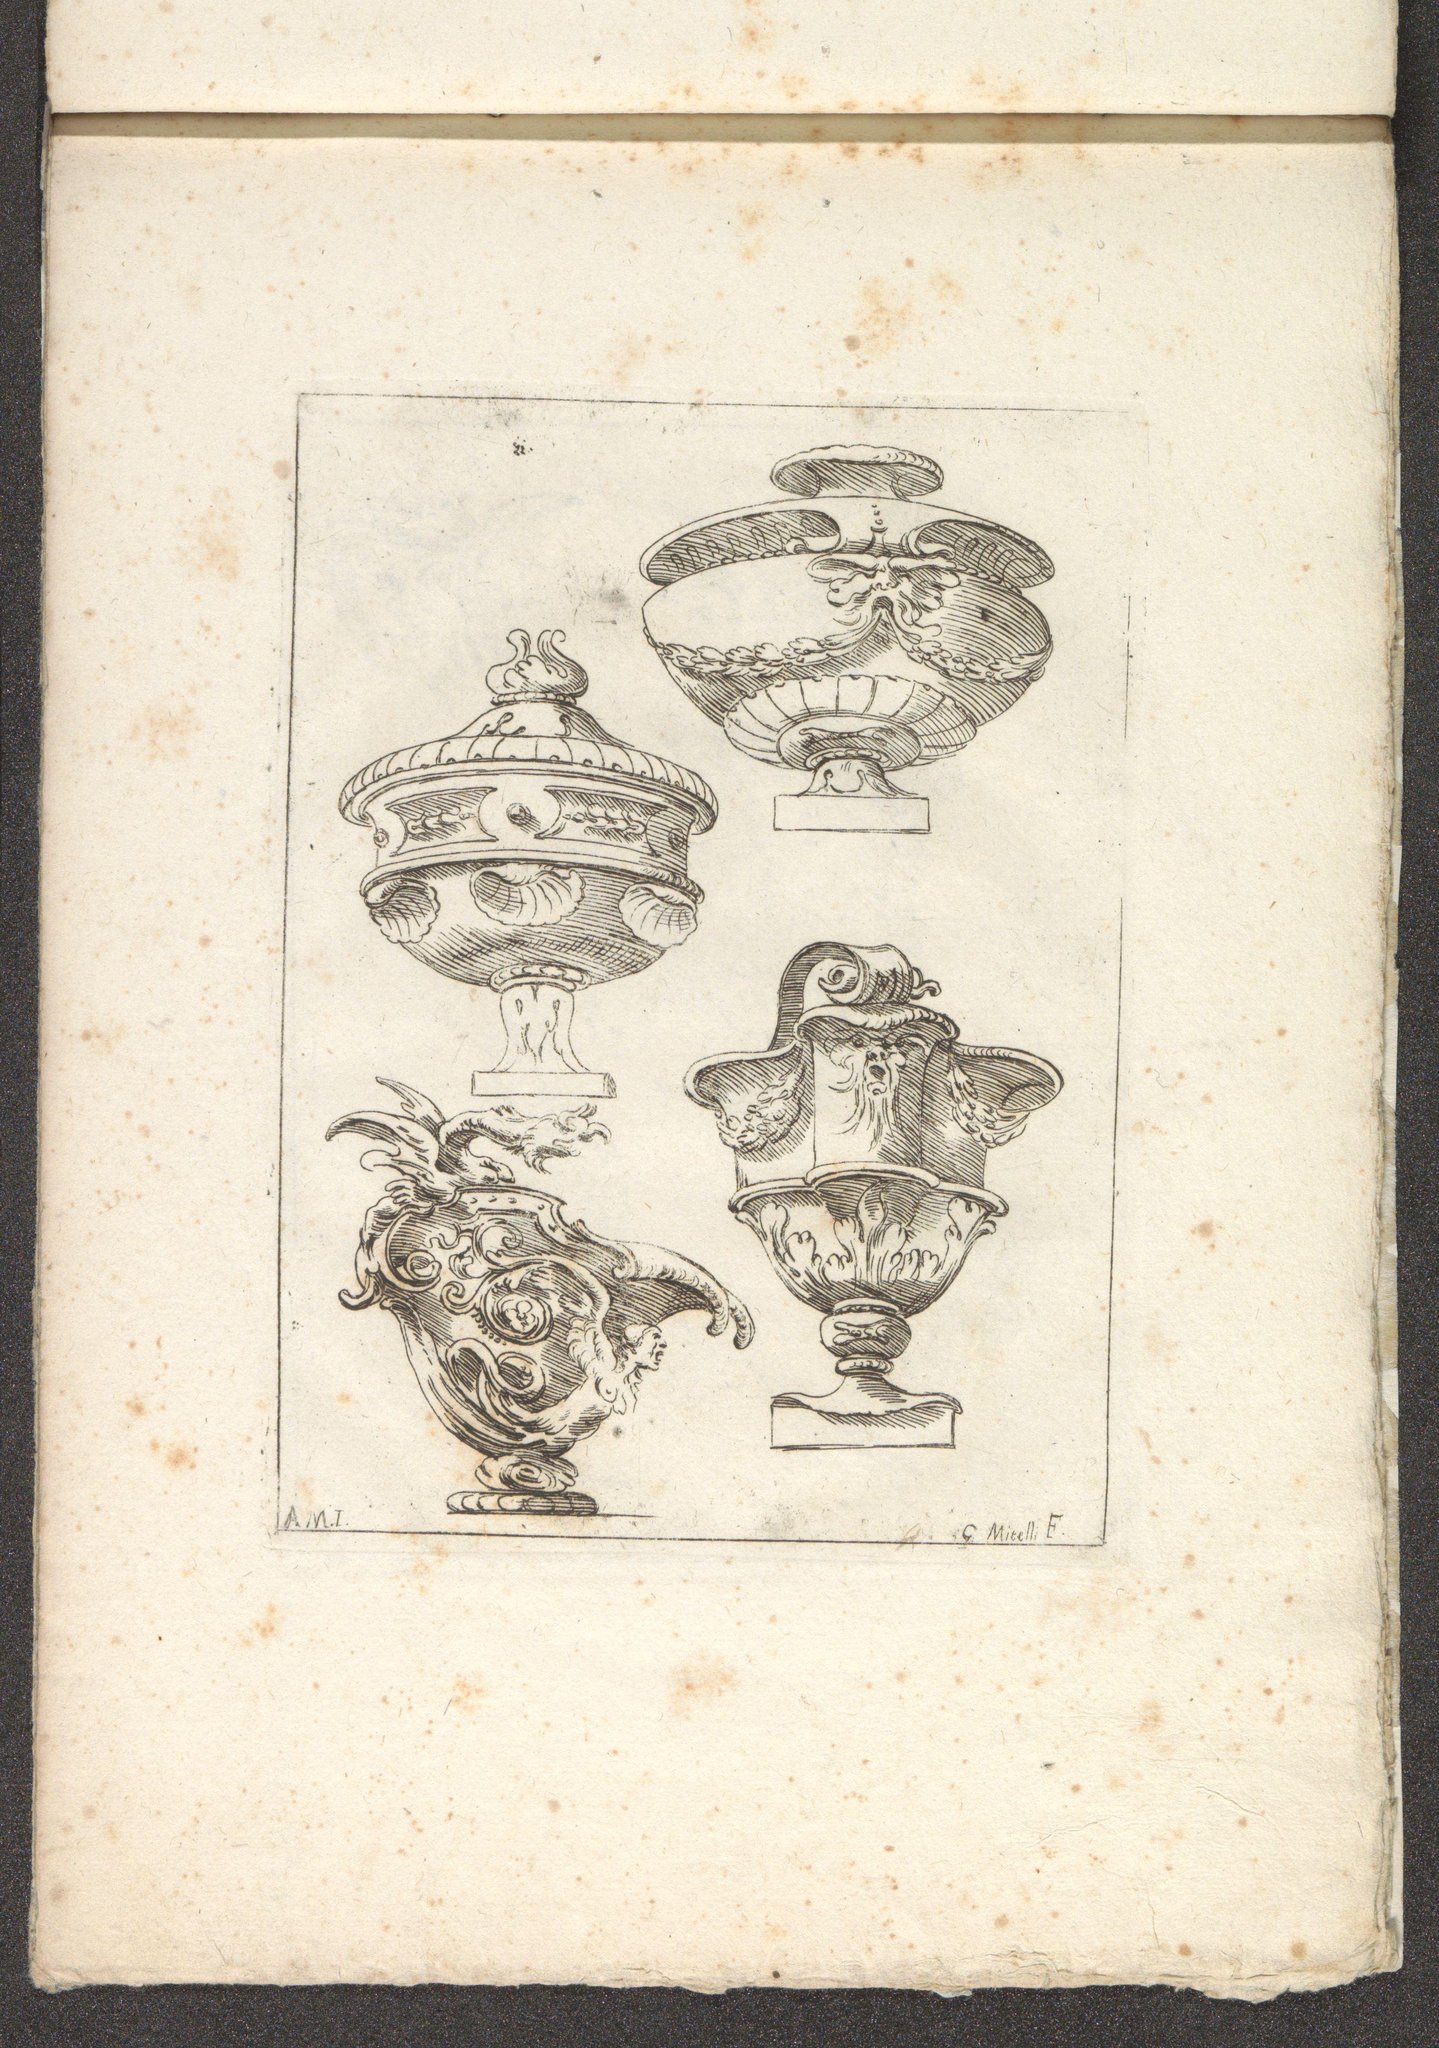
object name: ornament print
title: Twee vazen en twee kannen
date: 1644-1718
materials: paper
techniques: etching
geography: italy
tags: ornaments ~ art, vase ~ ornament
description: Twee ornamentele vazen en twee ornamentele kannen. De prent maakt deel uit van een album.